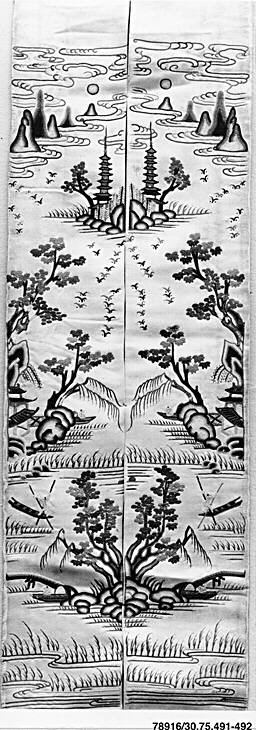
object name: sleeve band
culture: chinese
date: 1801-1900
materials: metal thread, silk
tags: landscapes